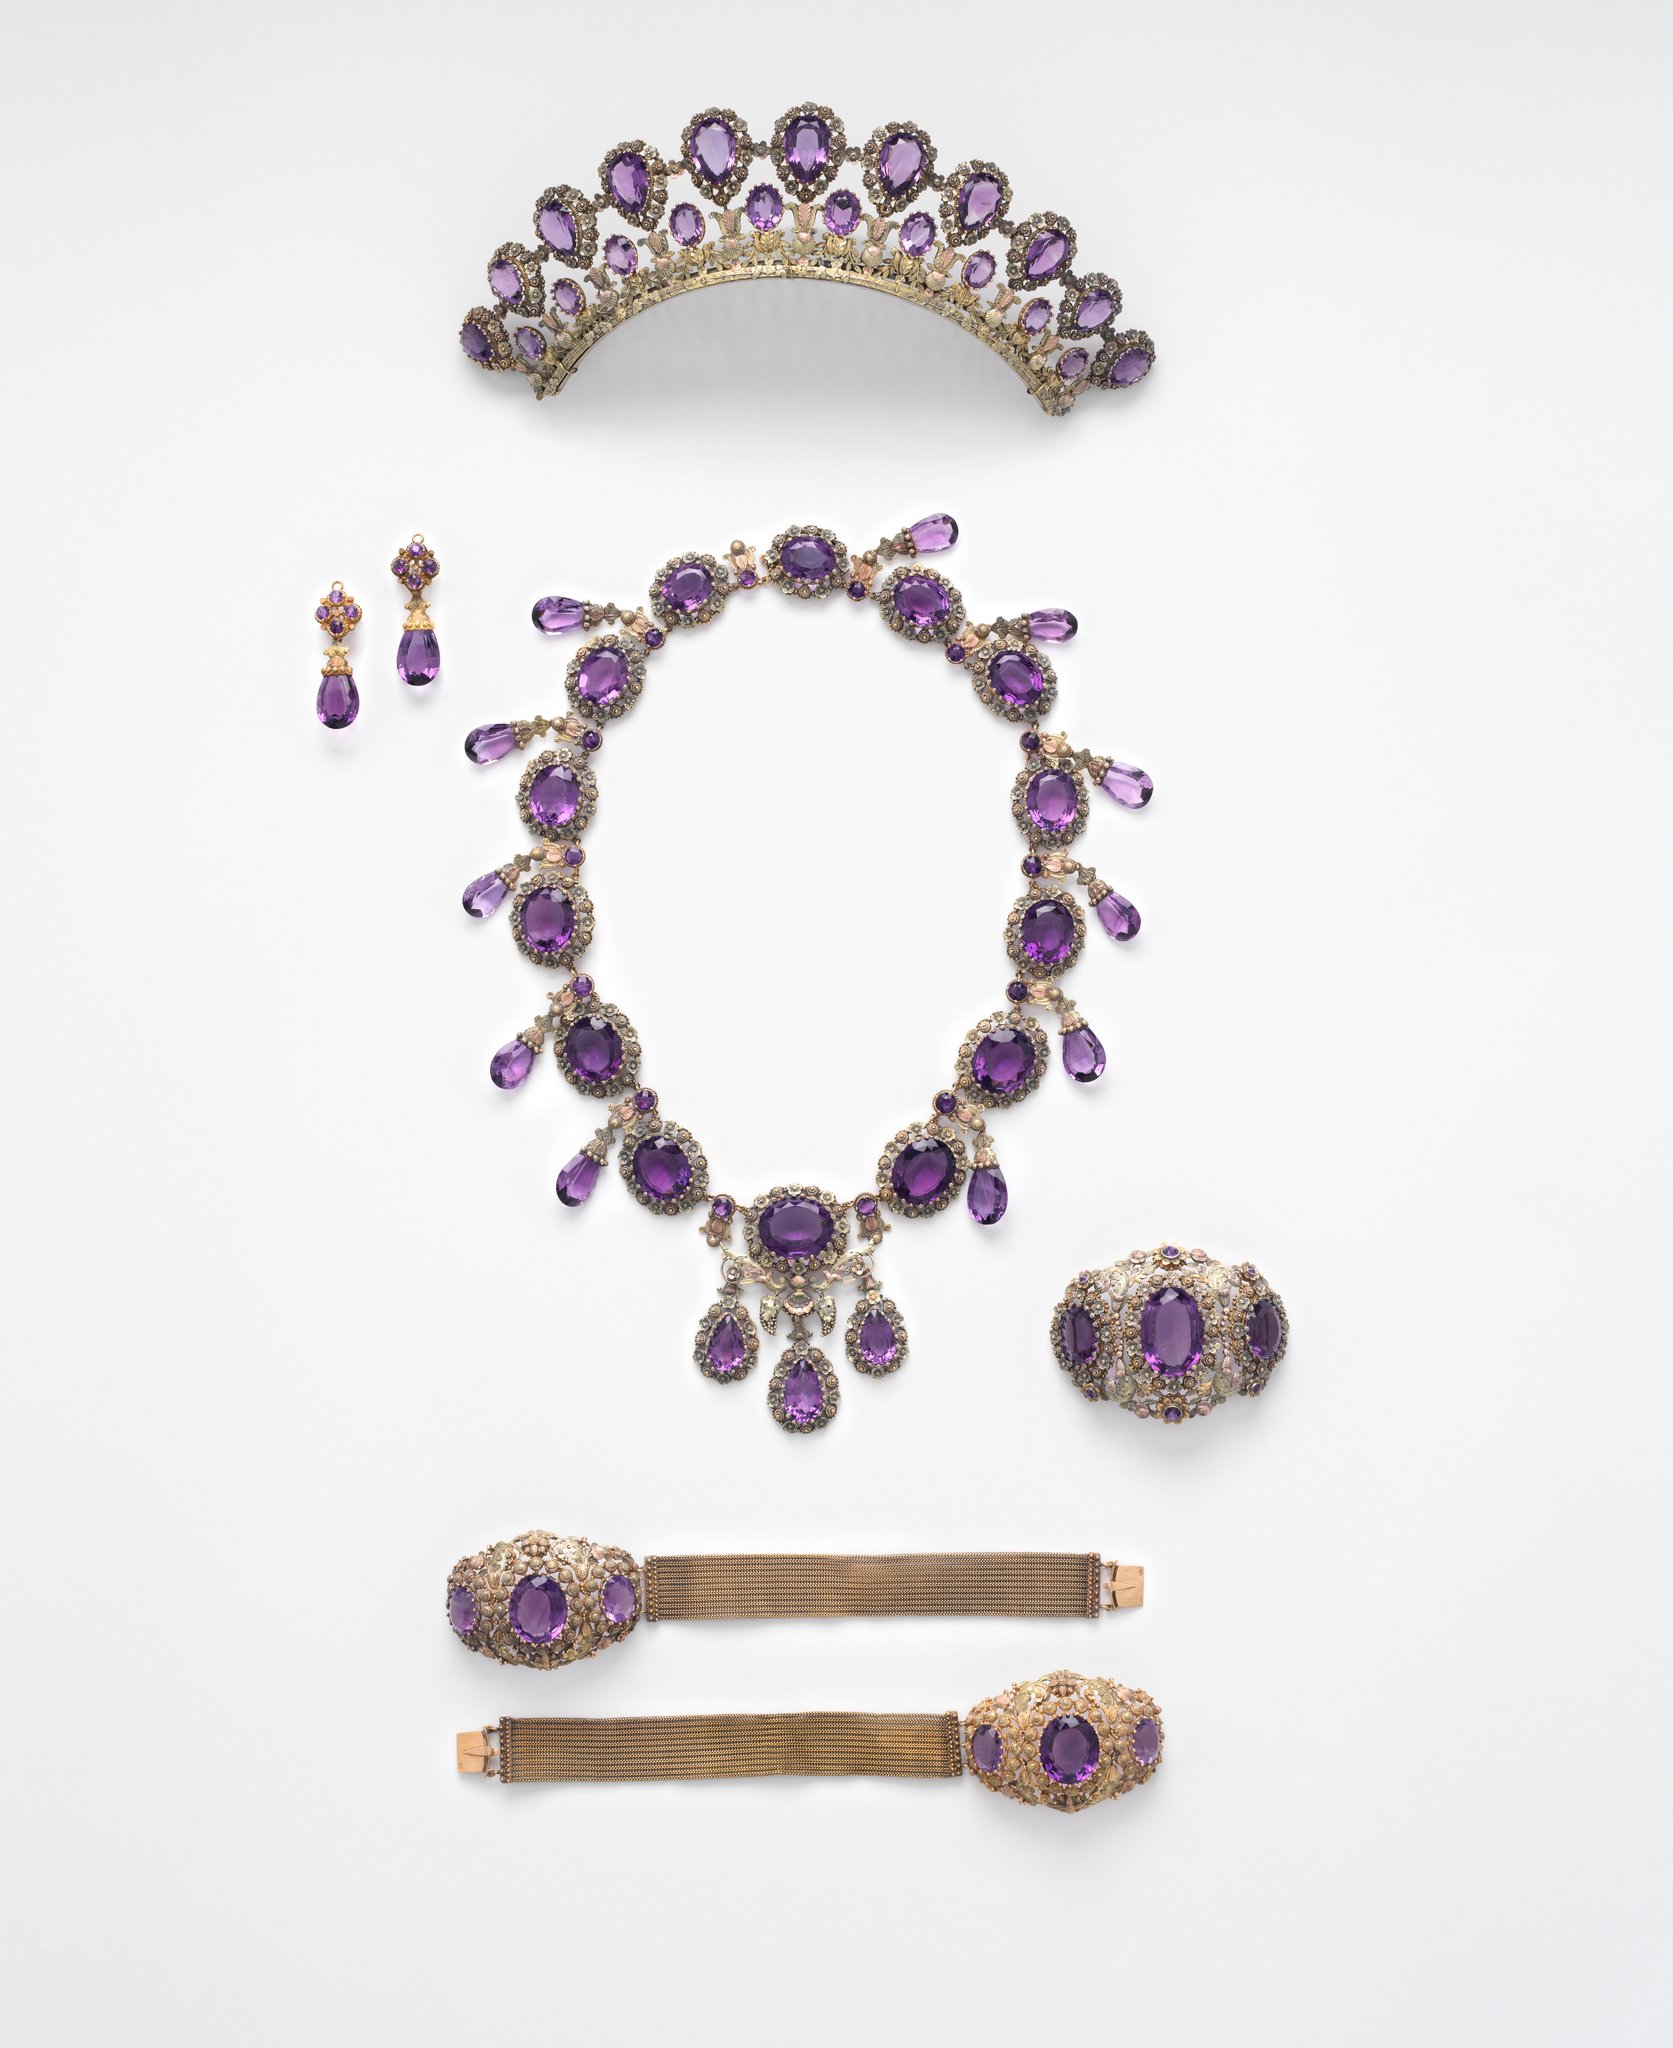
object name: earring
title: Pair of earrings (part of a set)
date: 1830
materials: amethyst, gold